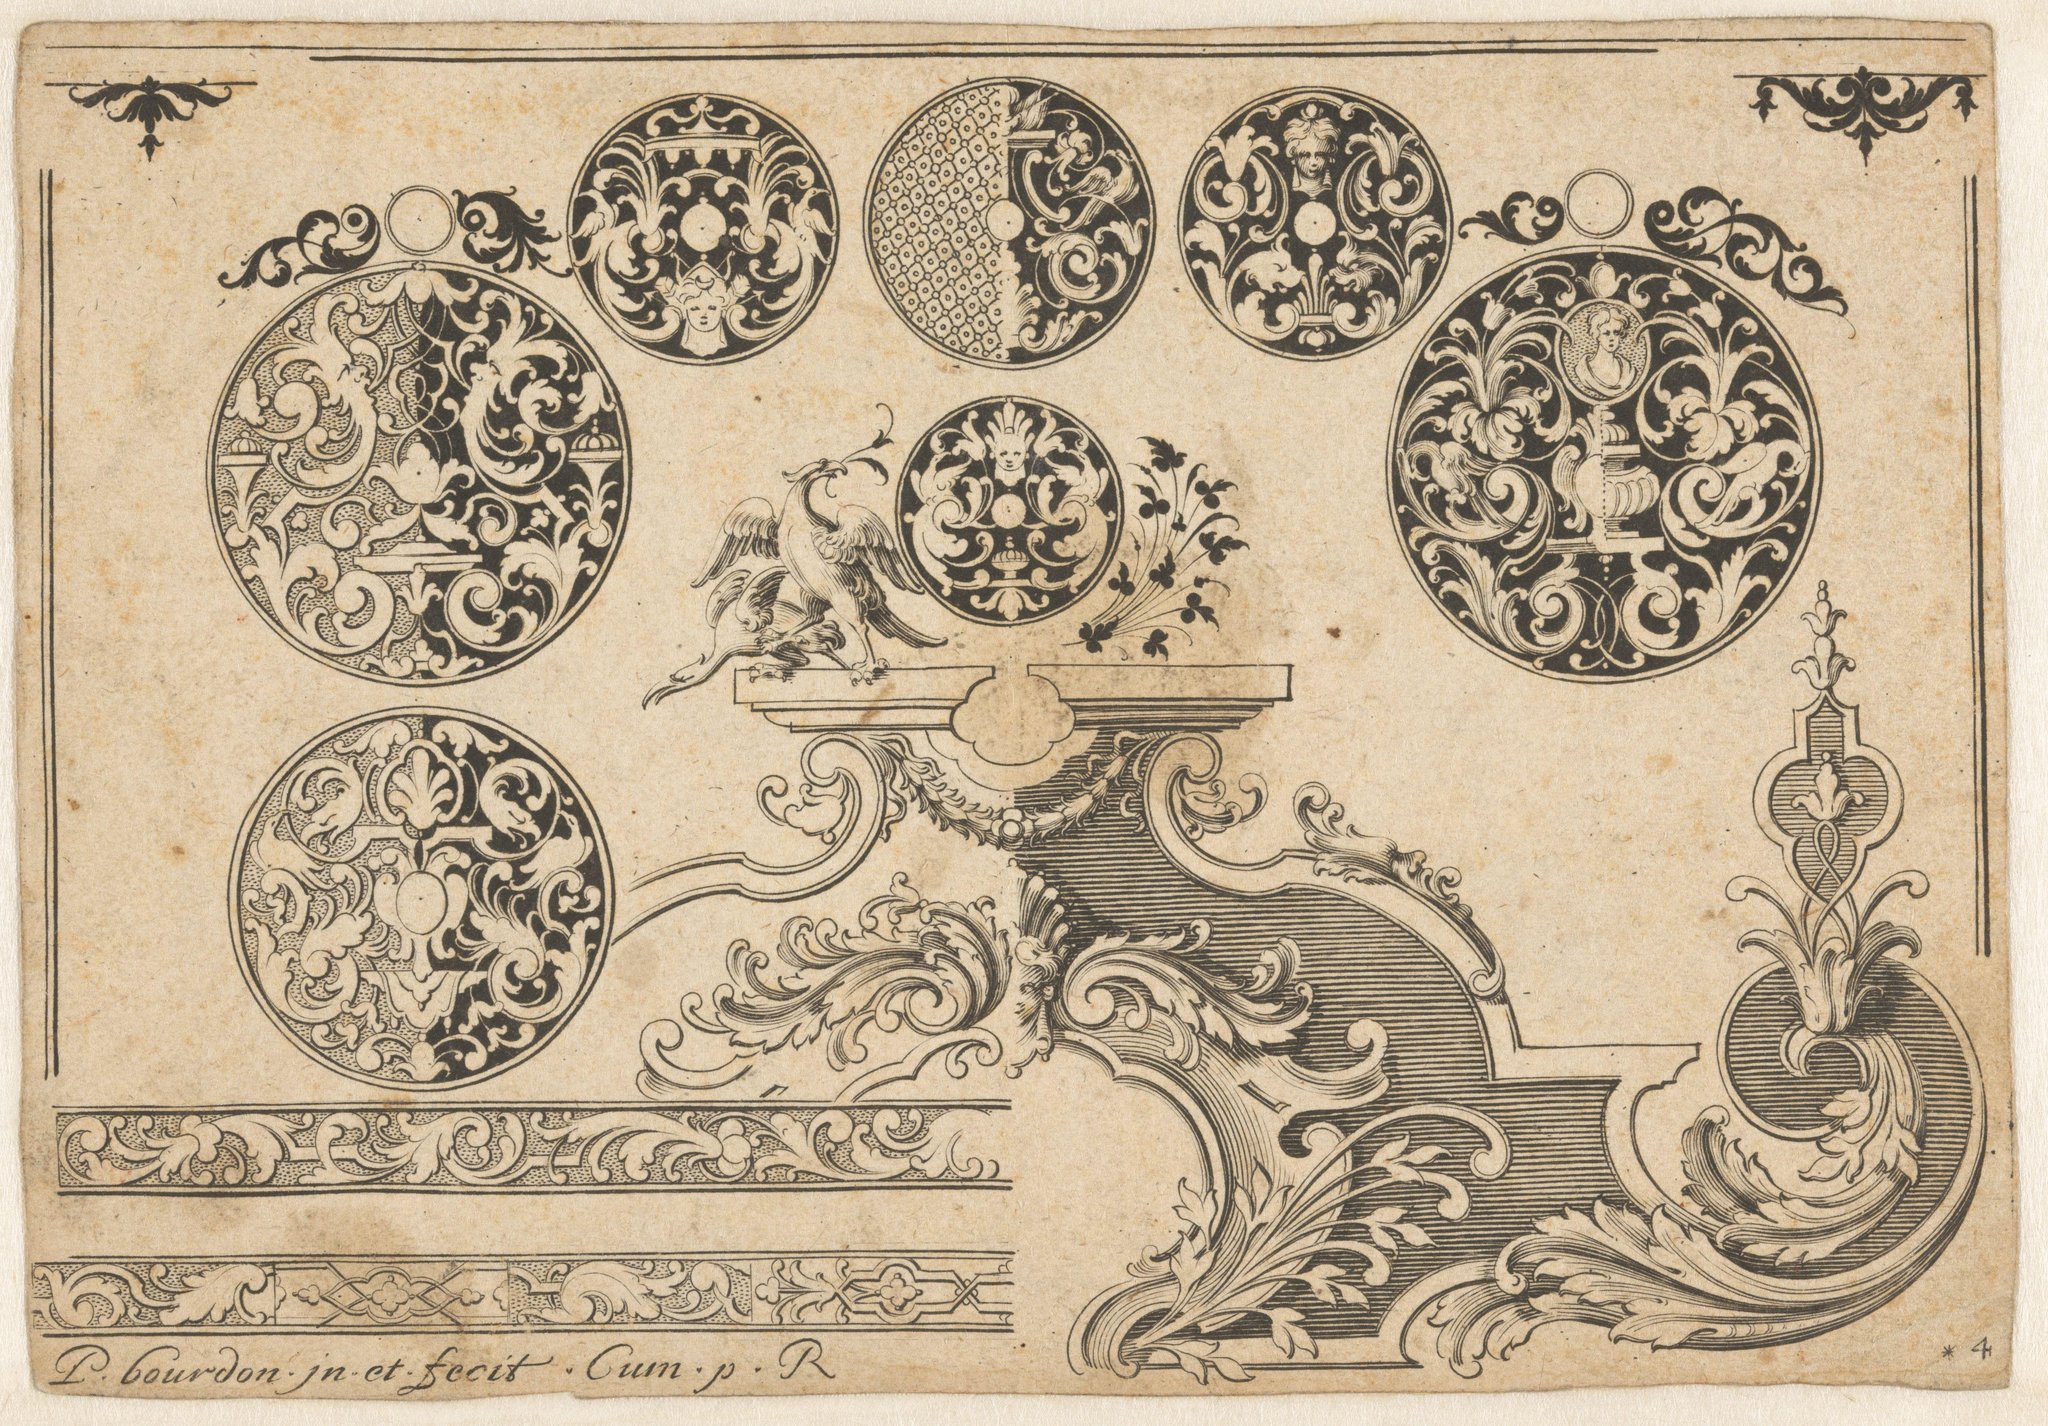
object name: print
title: Livre Second: Essais de gravure par Pierre Bourdon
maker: pierre bourdon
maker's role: print maker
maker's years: 1656-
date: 1703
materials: paper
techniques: engraving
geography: paris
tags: ornaments ~ art, watch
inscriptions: signature: ‘P. bourdon in et fecit’, privilege: ‘Cum p. R’, number: ‘*4’, collector's mark: Lugt 2760, collector's mark: Lugt 2228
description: Blad uit serie van zeven van ontwerpen voor horlogemakers, goudsmeden, beeldhouwers en graveurs.